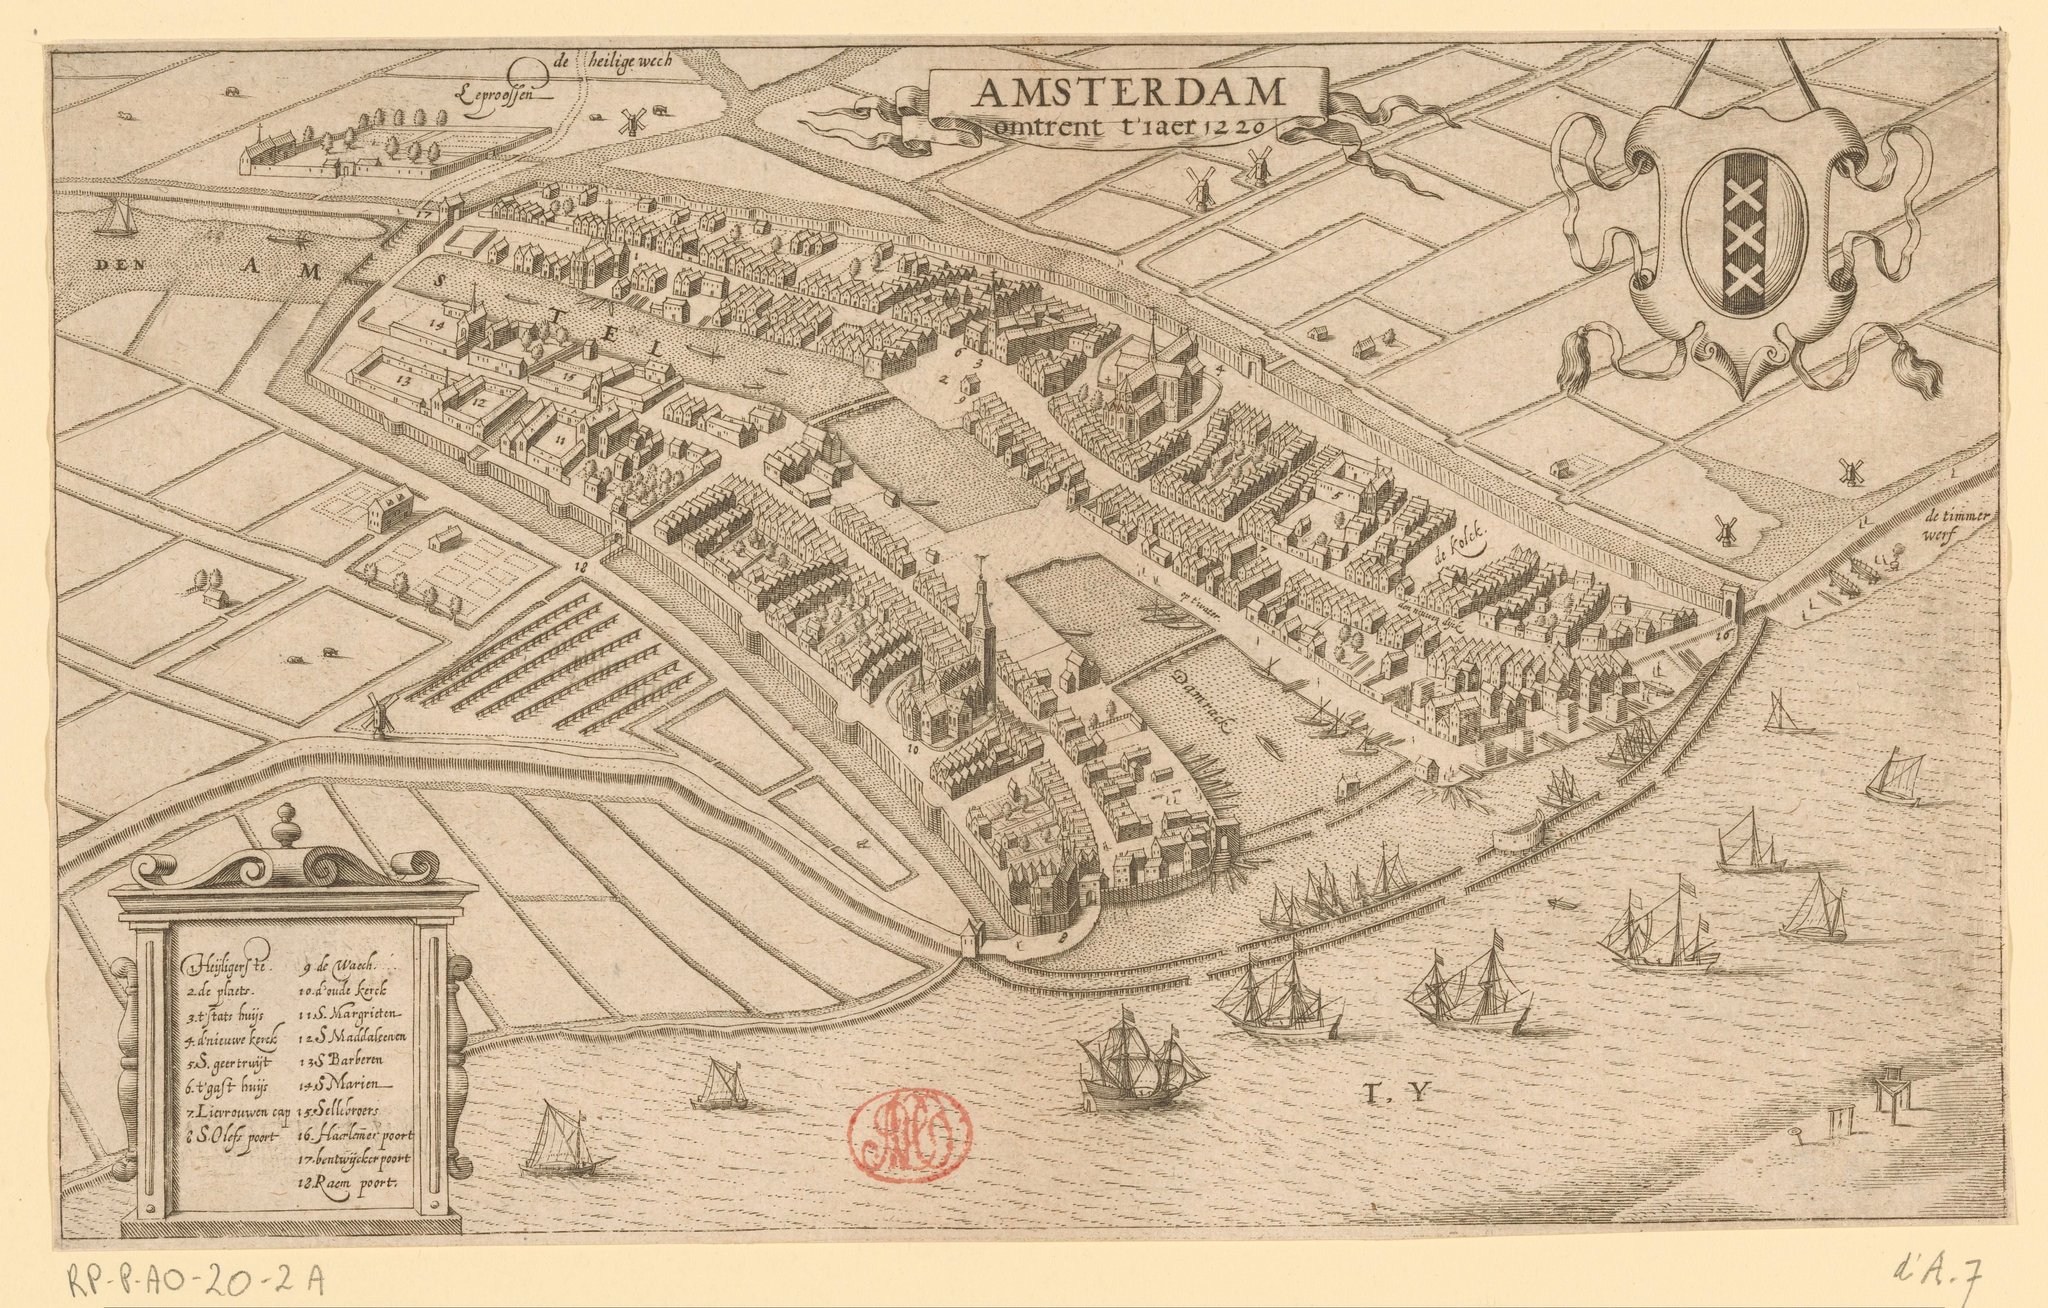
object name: area plan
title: Plattegrond van Amsterdam, 1220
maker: Anonymous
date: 1613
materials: paper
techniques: engraving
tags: coat of arms (as symbol of the state, etc.) (+ city; municipal), maps of cities, amsterdam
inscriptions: collector's mark: Lugt 195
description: Plattegrond van Amsterdam zoals het er in 1220 uit zou hebben gezien, in vogelvluchtperspectief. Boven in het midden een banderol met de titel. Rechtsboven het wapen van de stad. Linksonder een cartouche met de legenda 1-18. Oriëntatie: westzuidwest boven.